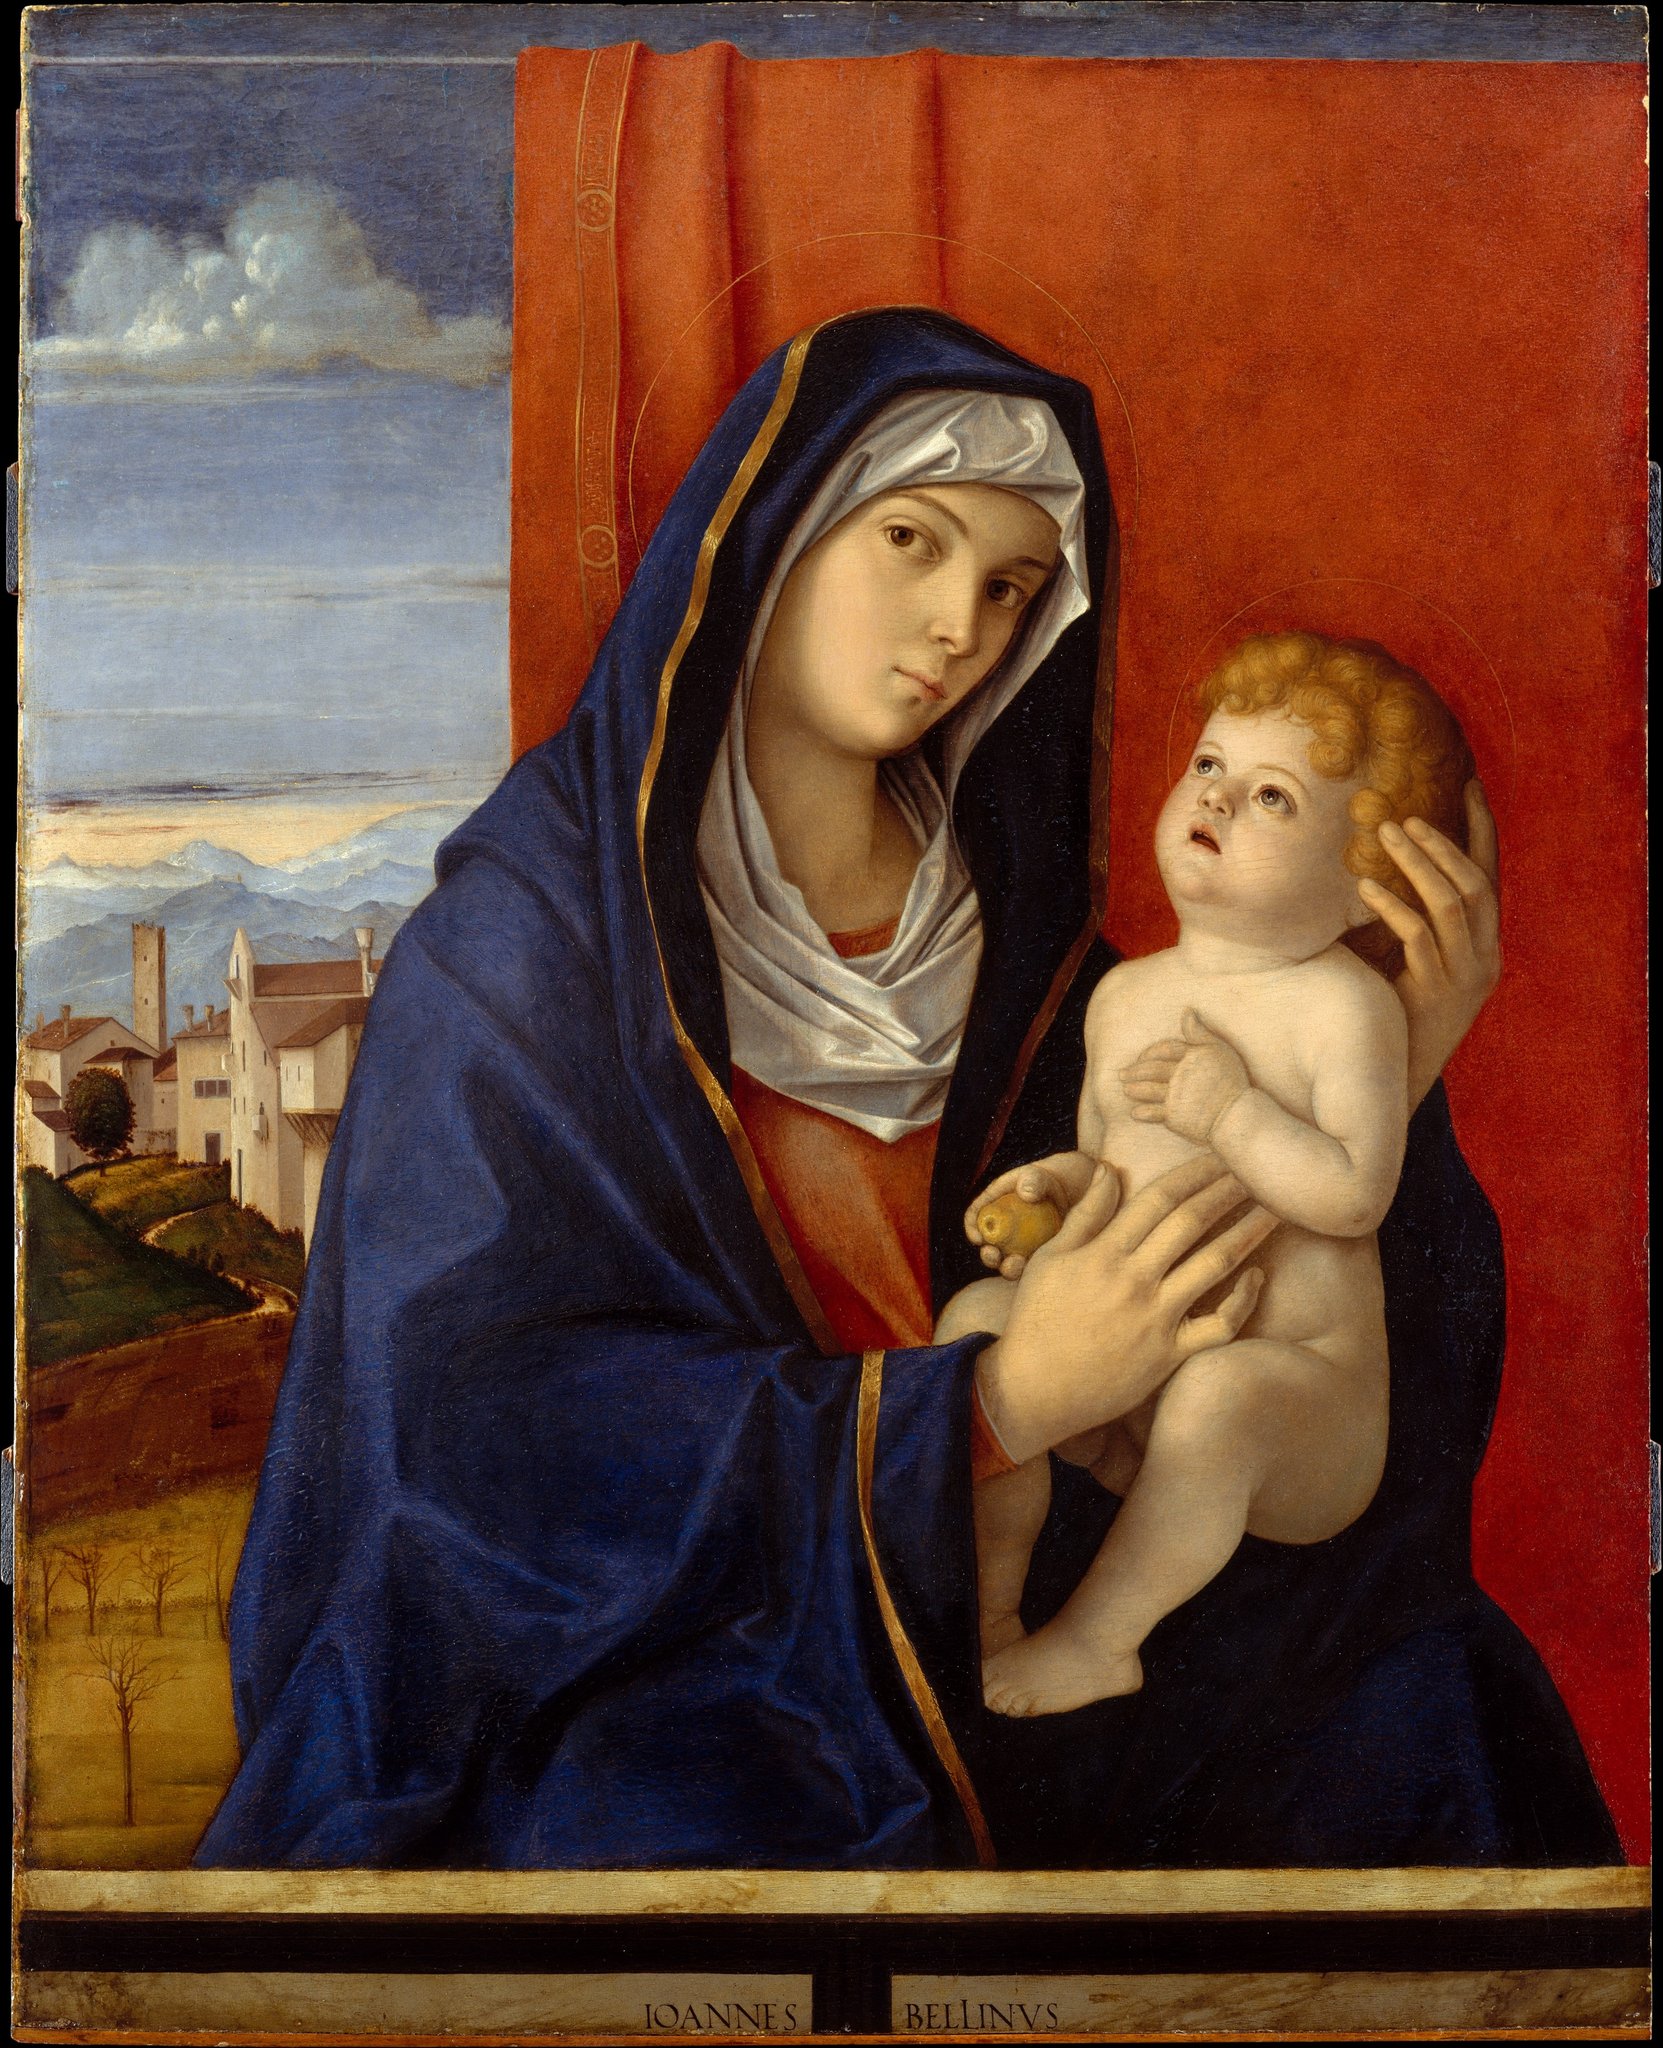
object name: painting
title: Madonna and Child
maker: giovanni bellini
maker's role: artist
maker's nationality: italian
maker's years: 1424-1516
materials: oil, wood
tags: infants,women,madonna,madonna and child,jesus